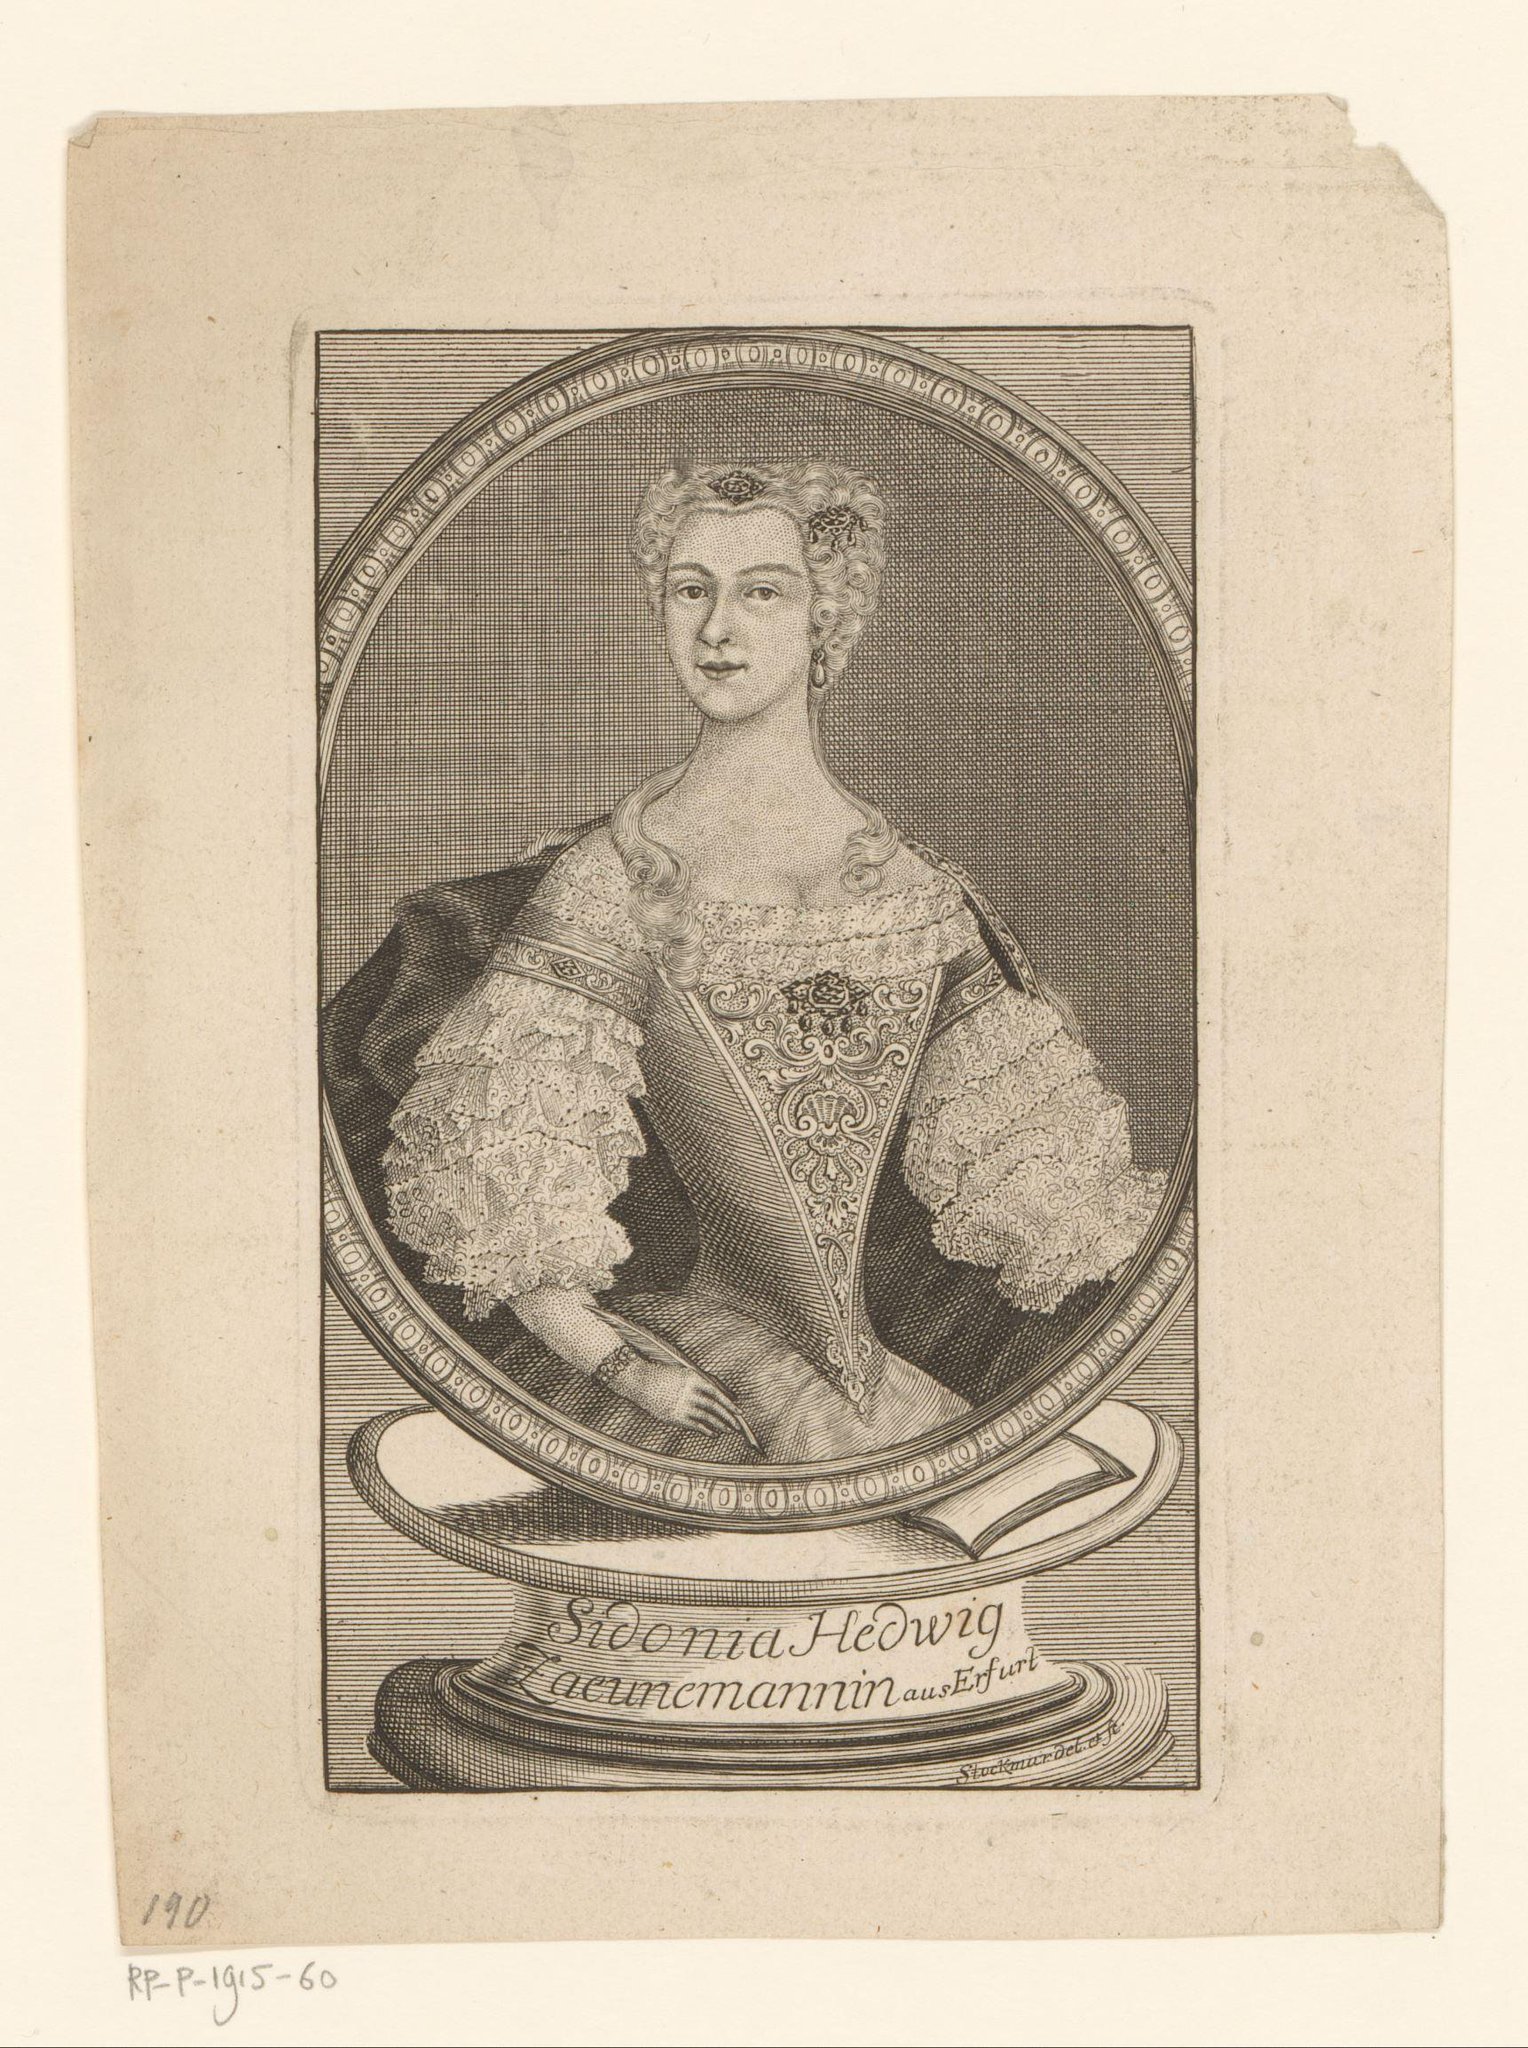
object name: print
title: Portret van Sidonia Hedwig Zäunemann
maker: johann wolfgang heinrich stockmar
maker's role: print maker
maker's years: 1707-1785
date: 1735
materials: paper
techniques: engraving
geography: germany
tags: historical persons - bb - woman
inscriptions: number: ‘190’, collector's mark: Lugt 2228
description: Prent gebruikt voor de publicatie: Hamburgische Berichte von den neuesten Gelehrten Sachen. Hamburg: s.n., 1735. Op verso een tekening in potlood van een slede.